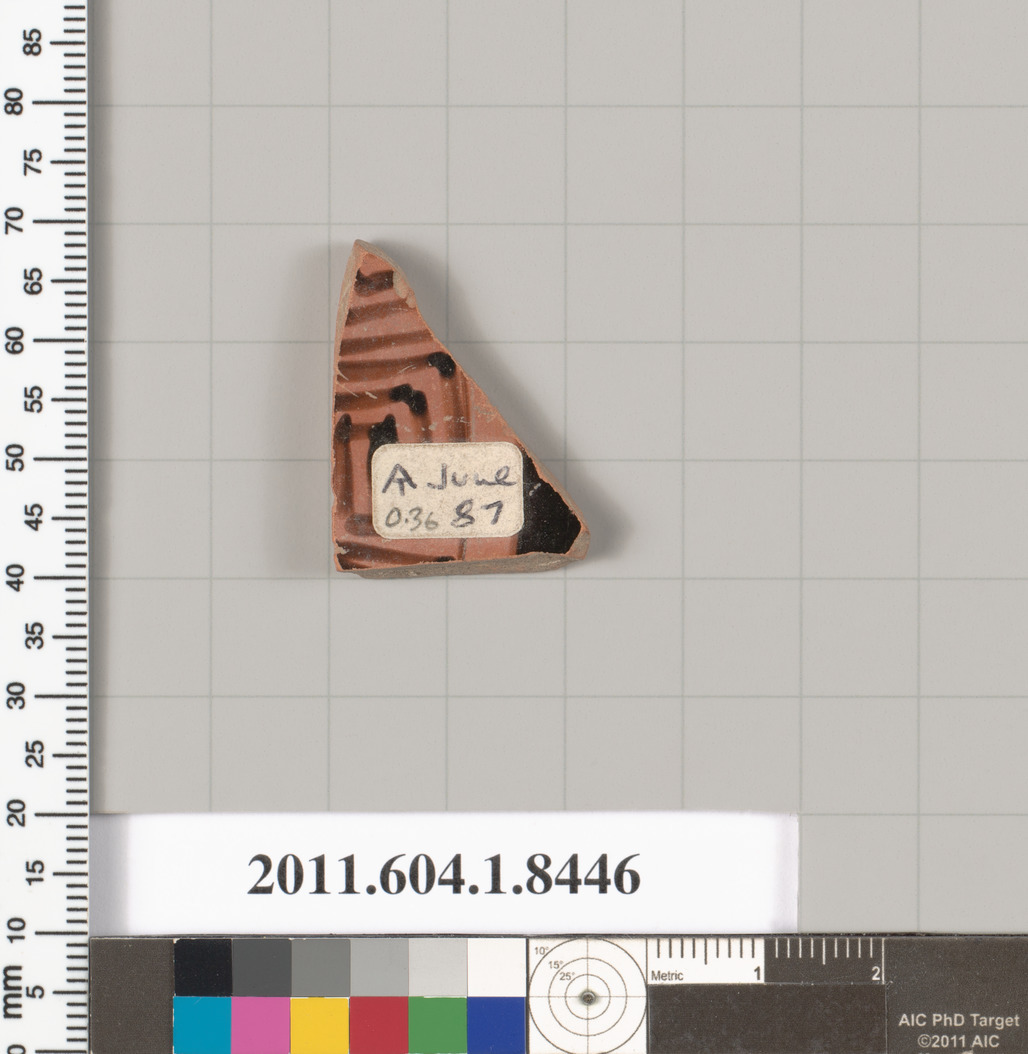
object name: kylix fragment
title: Terracotta fragment of a kylix (drinking cup)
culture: greek, attic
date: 375-351 BCE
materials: terracotta